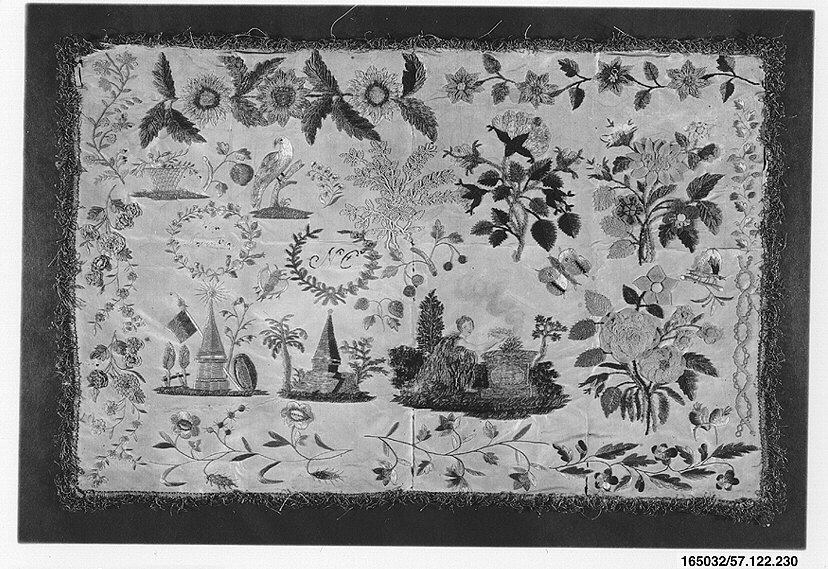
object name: sampler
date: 1801-1900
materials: silk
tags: birds,women